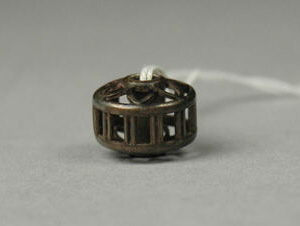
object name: ojime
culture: japanese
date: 1801-1900